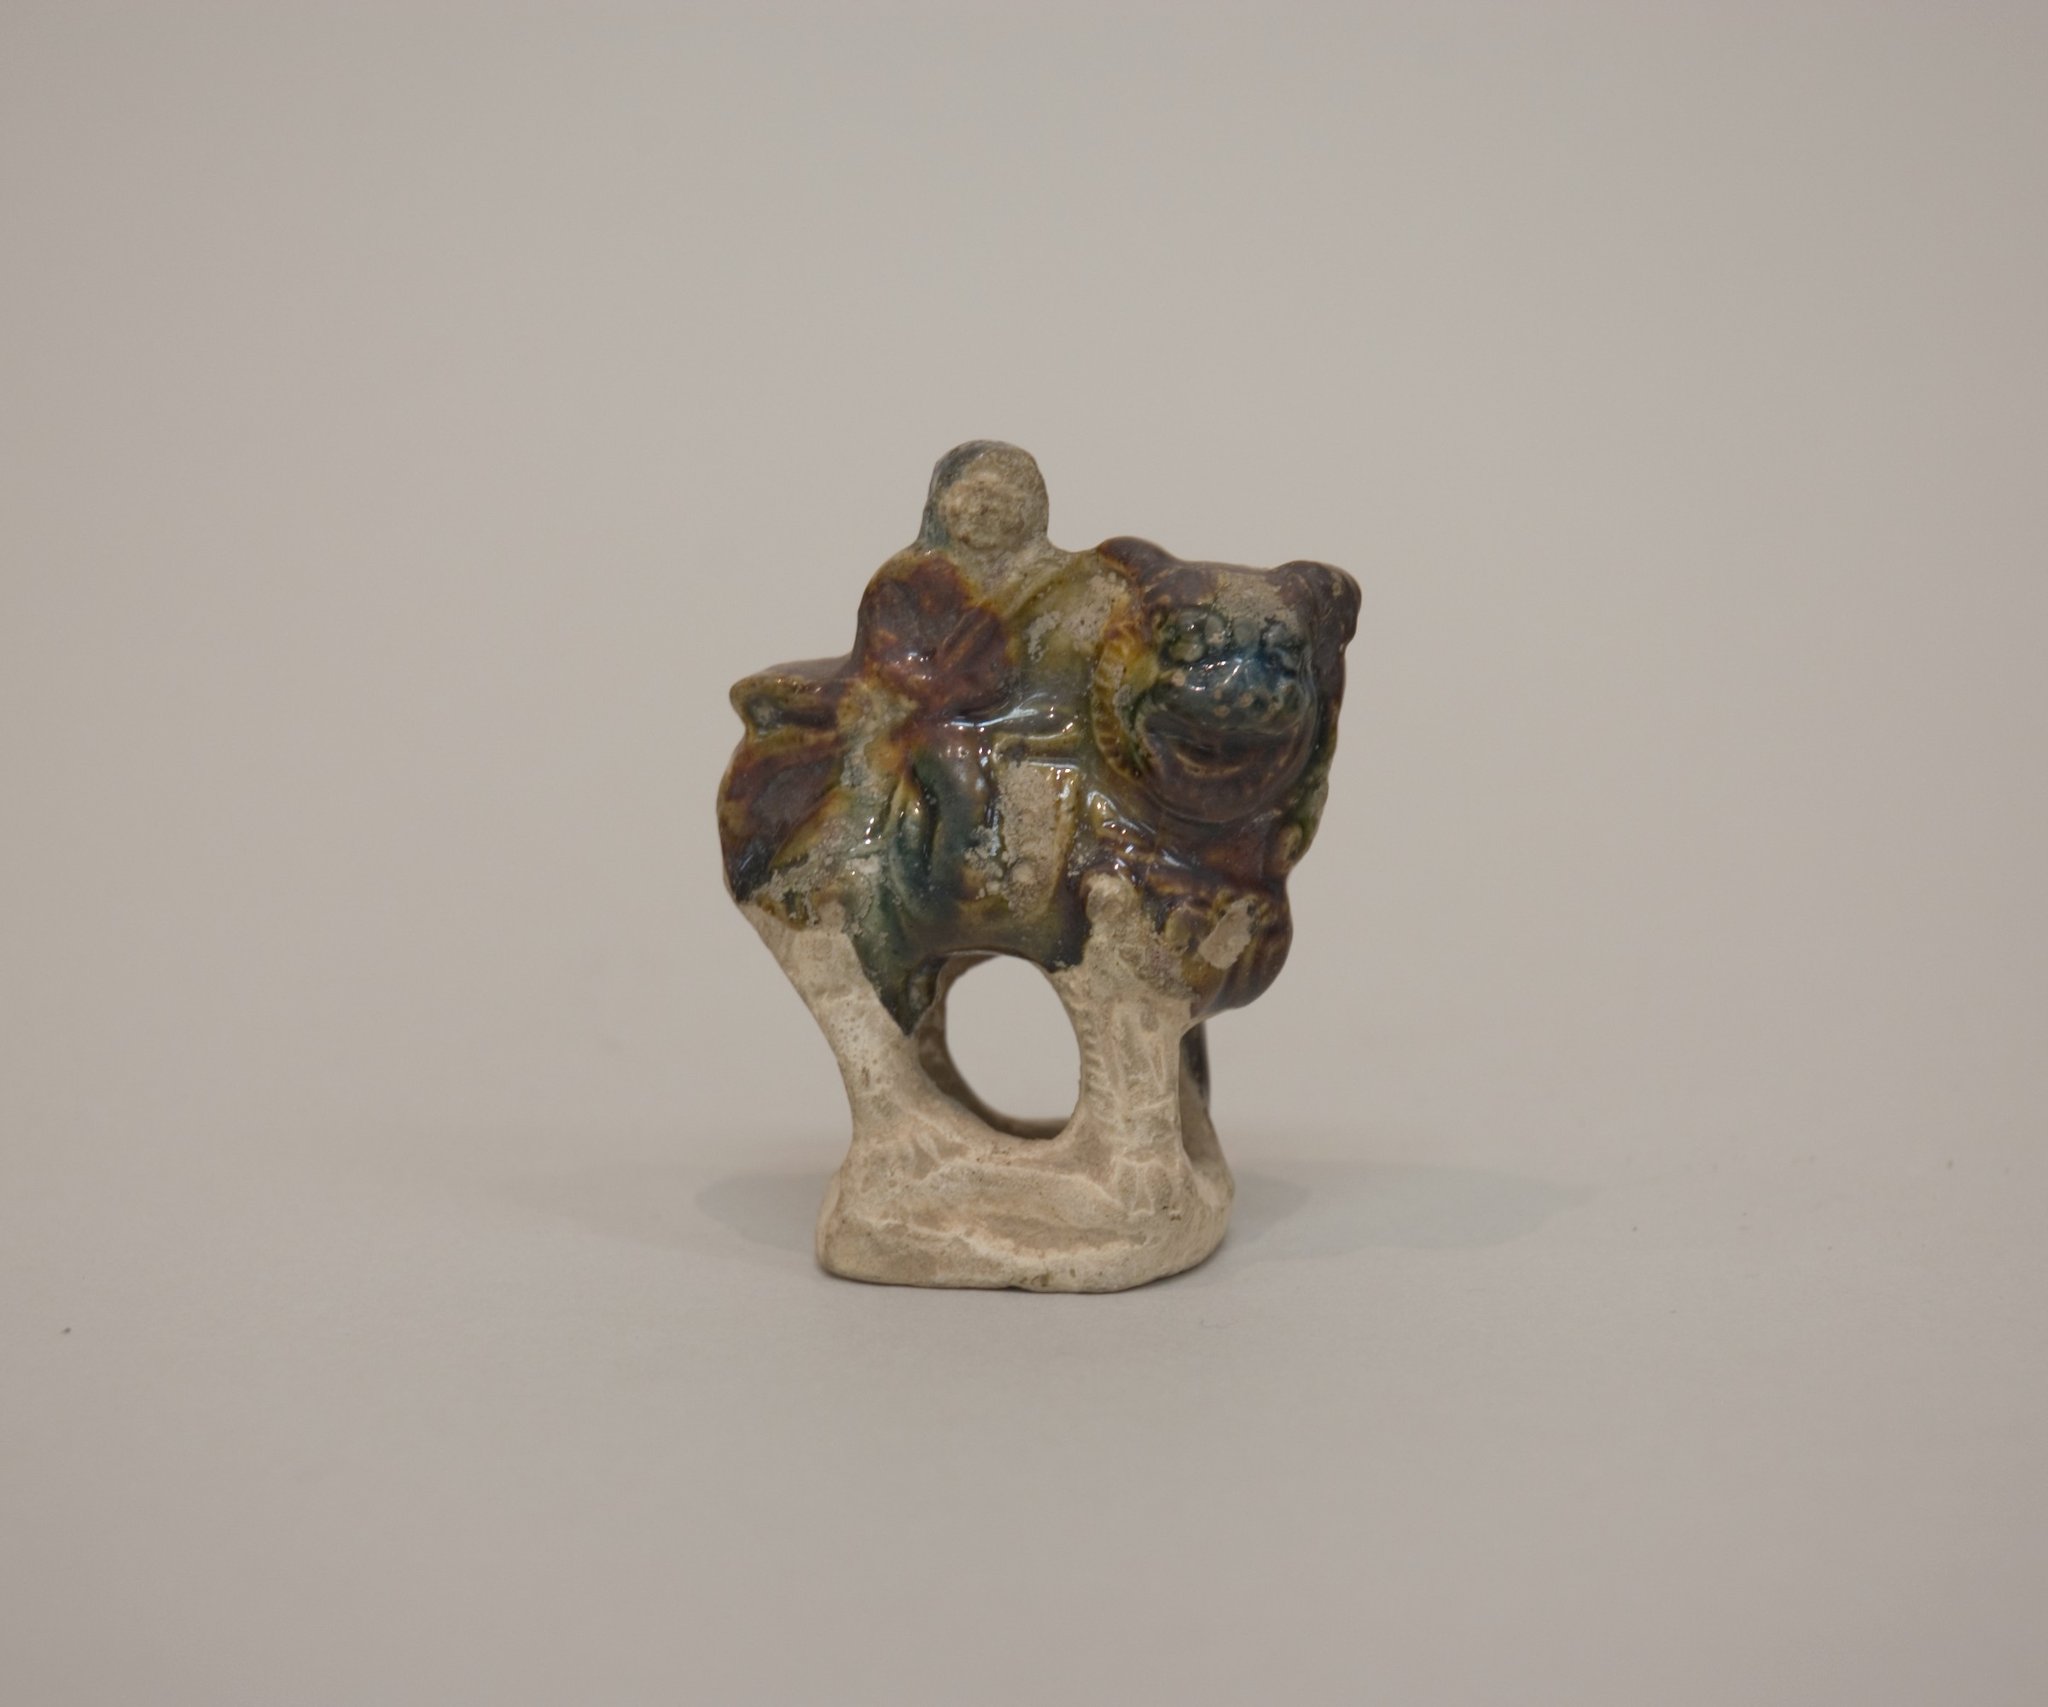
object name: tomb figure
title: Minature figure of a lion and rider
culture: chinese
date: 701-800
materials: earthenware, glaze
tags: men,lions